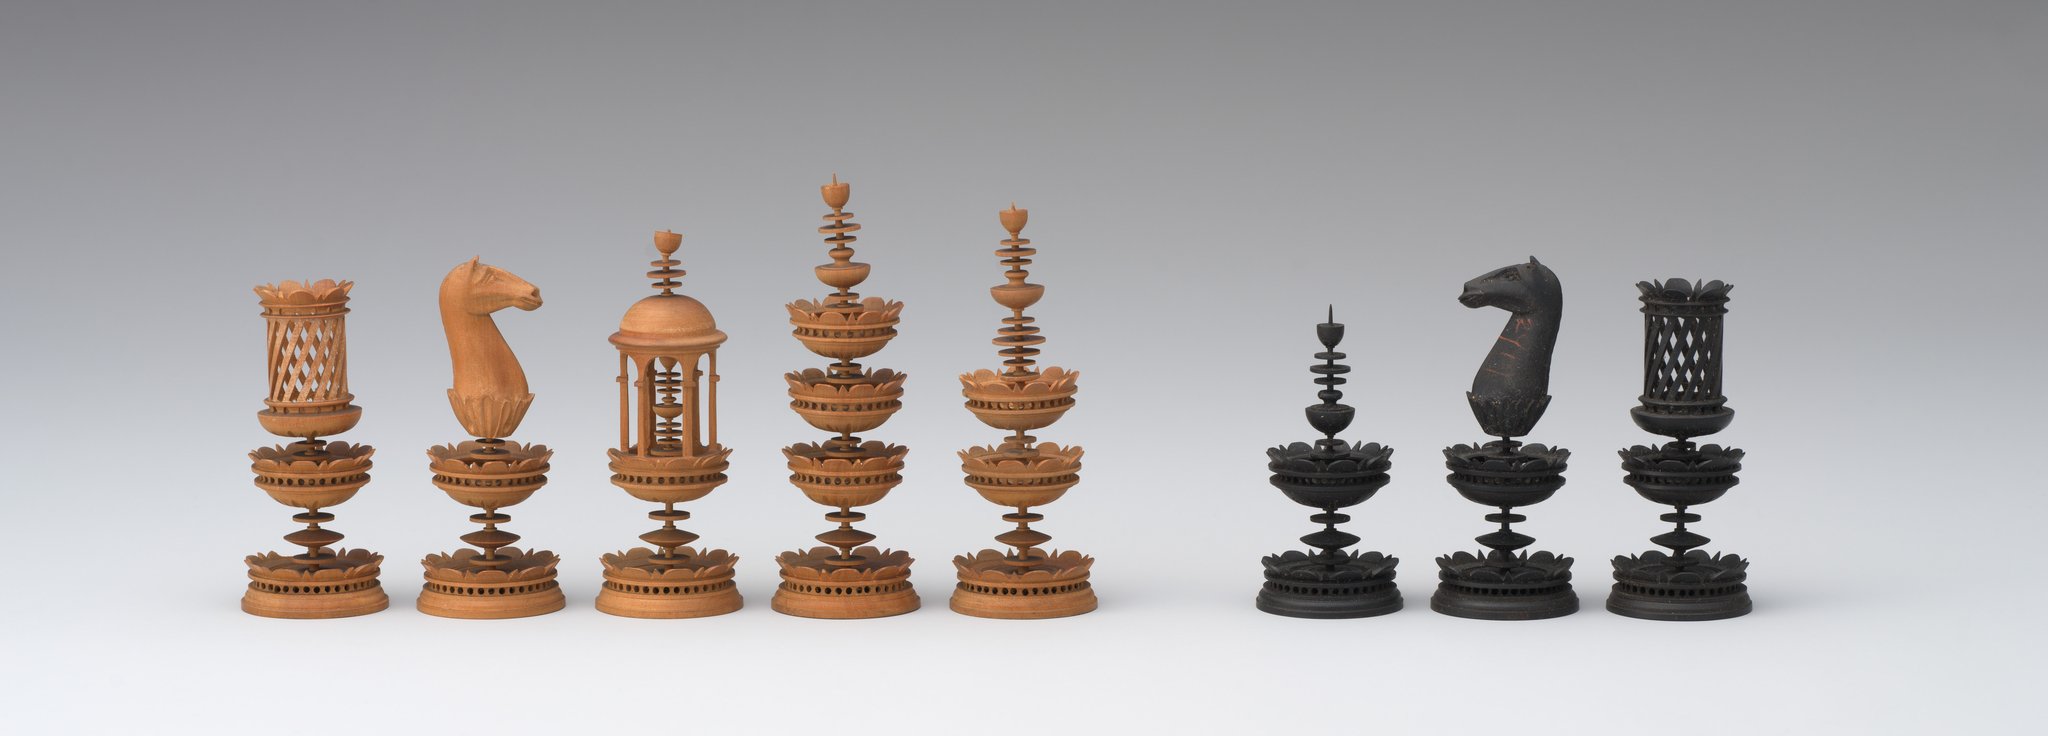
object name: chessman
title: Chessmen (9)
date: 1801-1833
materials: wood